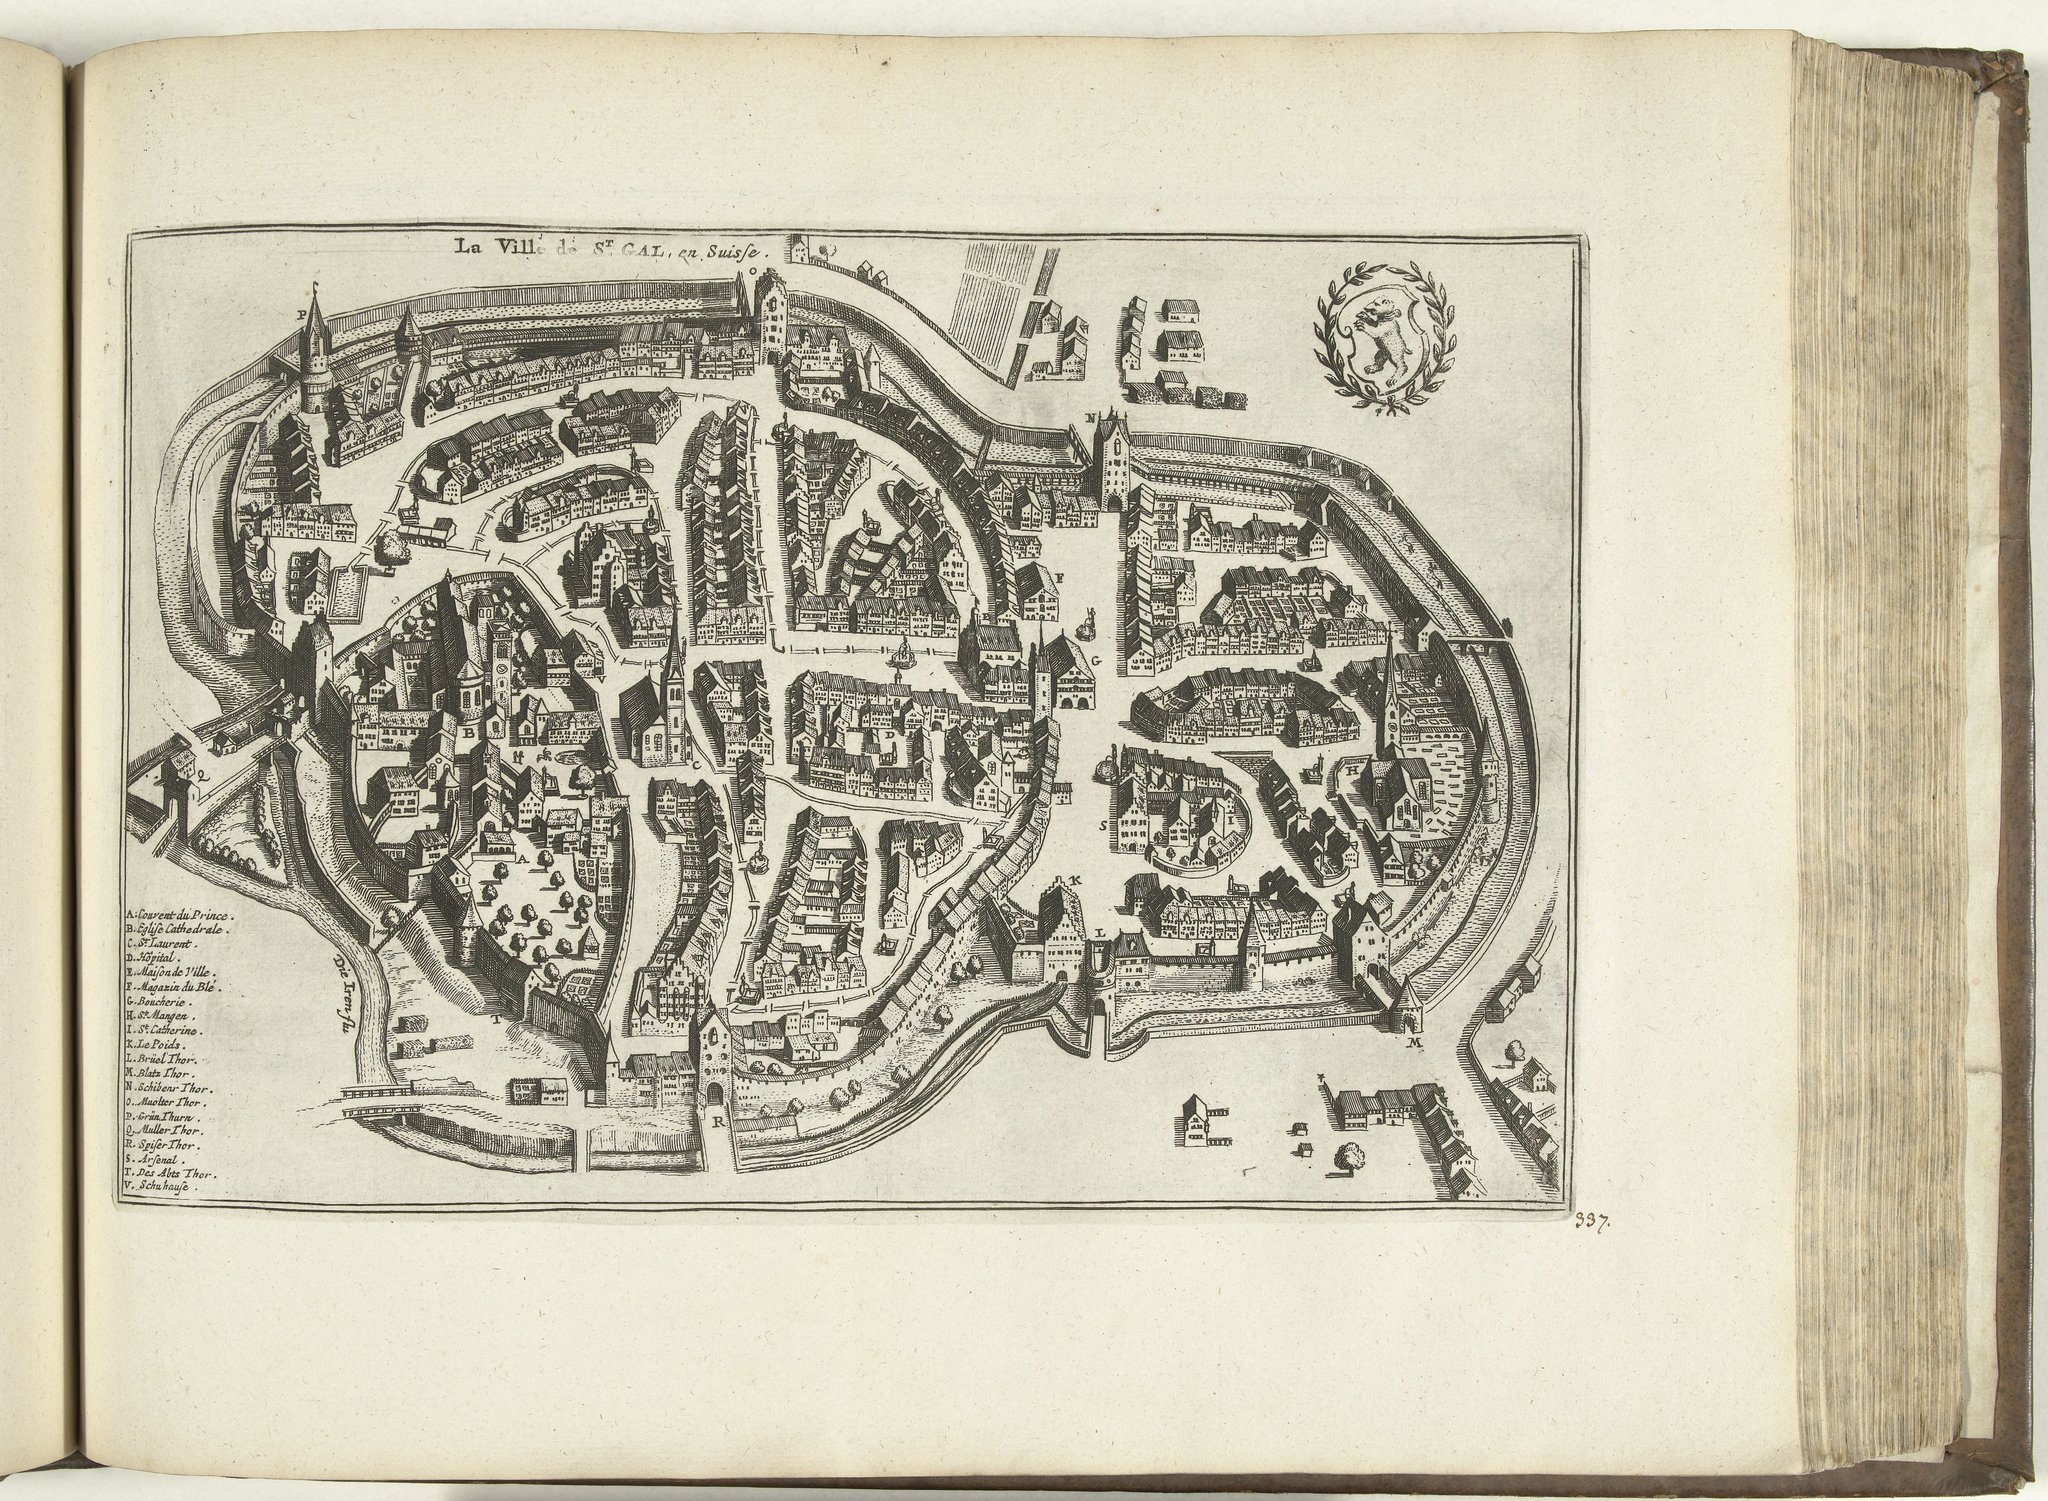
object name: print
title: Les Forces de l'Europe, Asie, Afrique et Amerique (...) Comme aussi les Cartes des Côtes de France et d'Espagne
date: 1726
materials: paper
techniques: etching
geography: leiden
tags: maps of cities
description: Plattegrond van Sankt Gallen in Zwitserland. Plaat nr. 337 in deel XIV van het prentwerk: Les Forces de l'Europe, Asie, Afrique et Amerique ... Comme aussi les Cartes des Côtes de France et d'Espagne uit 1726, dit tweede deel met 271 met de hand genummerde platen van vermaarde sterke steden en vestingen in het kader van de Spaanse Successieoorlog 1701-1713. Voor het merendeel zijn deze platen gekopieerd naar de anonieme Franse platen van vermaarde sterke steden en vestingen: in Les forces de l'Europe en in: Le theatre de la guerre, dans les Pays-Bas, beide oorspronkelijk uitgegeven door Nicolas de Fer te Parijs (1693-1697) in het kader van de Negenjarige Oorlog. Titel en opschriften in het Frans.